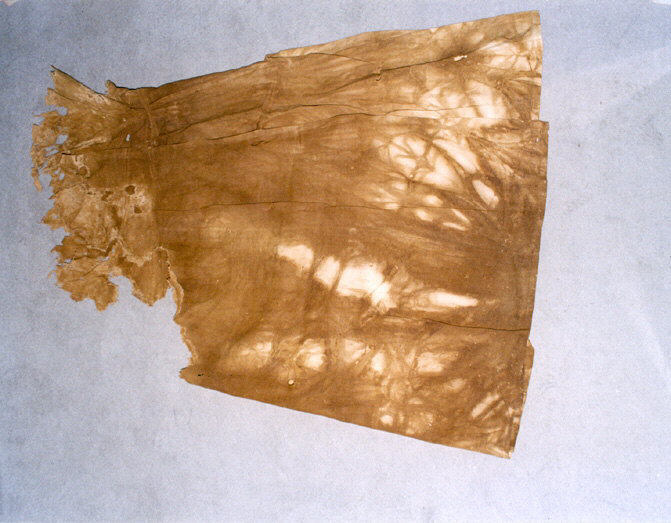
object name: textile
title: Skirting of a linen kaftan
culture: alanic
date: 601-900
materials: linen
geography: caucasus